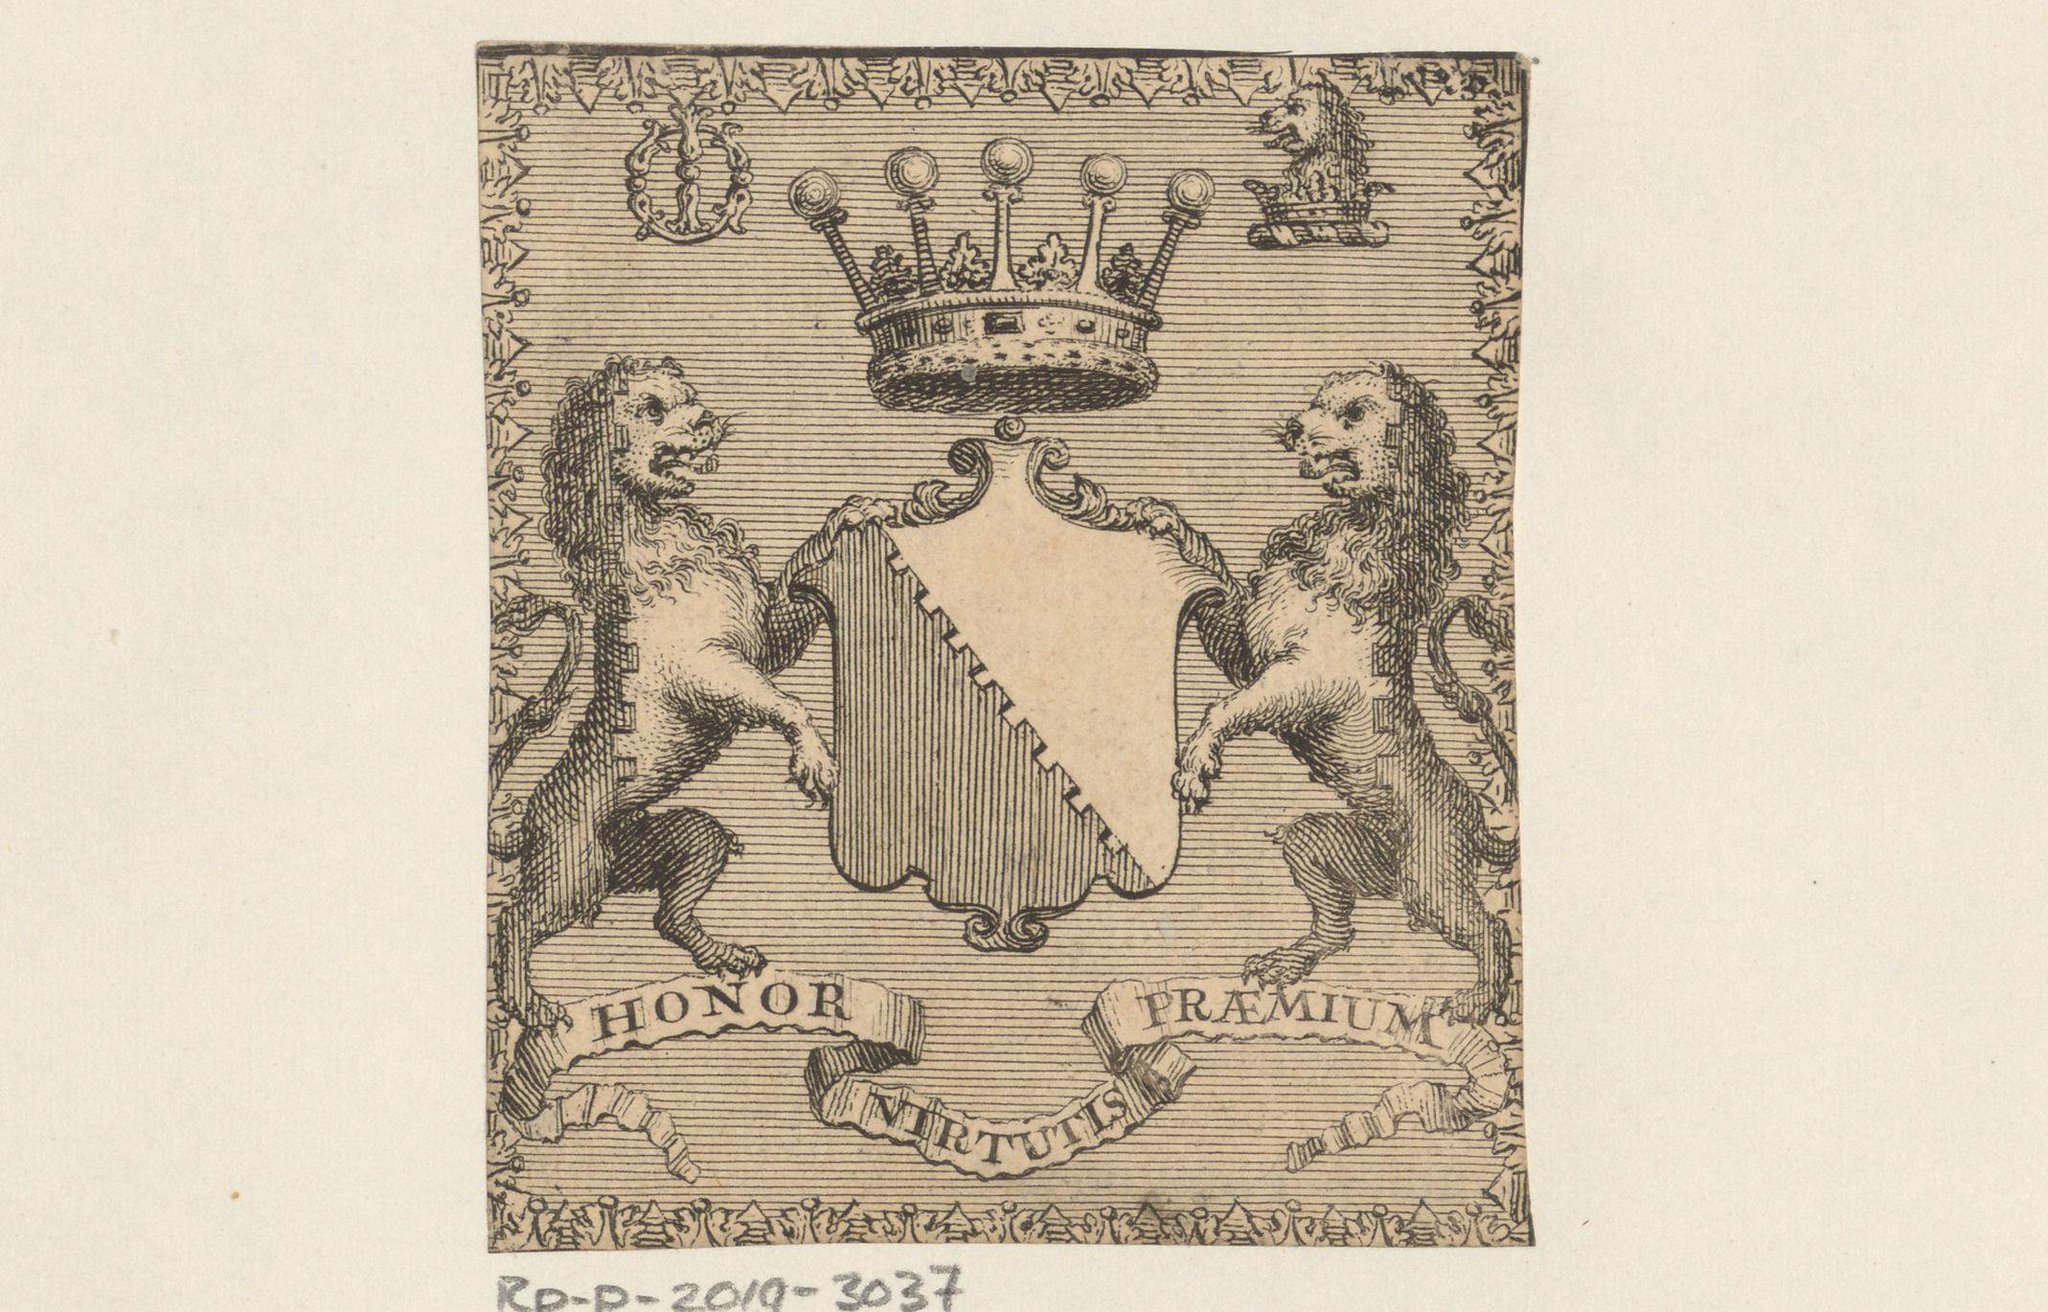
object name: bookplate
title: Honor virtutis praemium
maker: Anonymous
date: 1700-1799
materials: paper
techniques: etching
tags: armorial bearing, heraldry